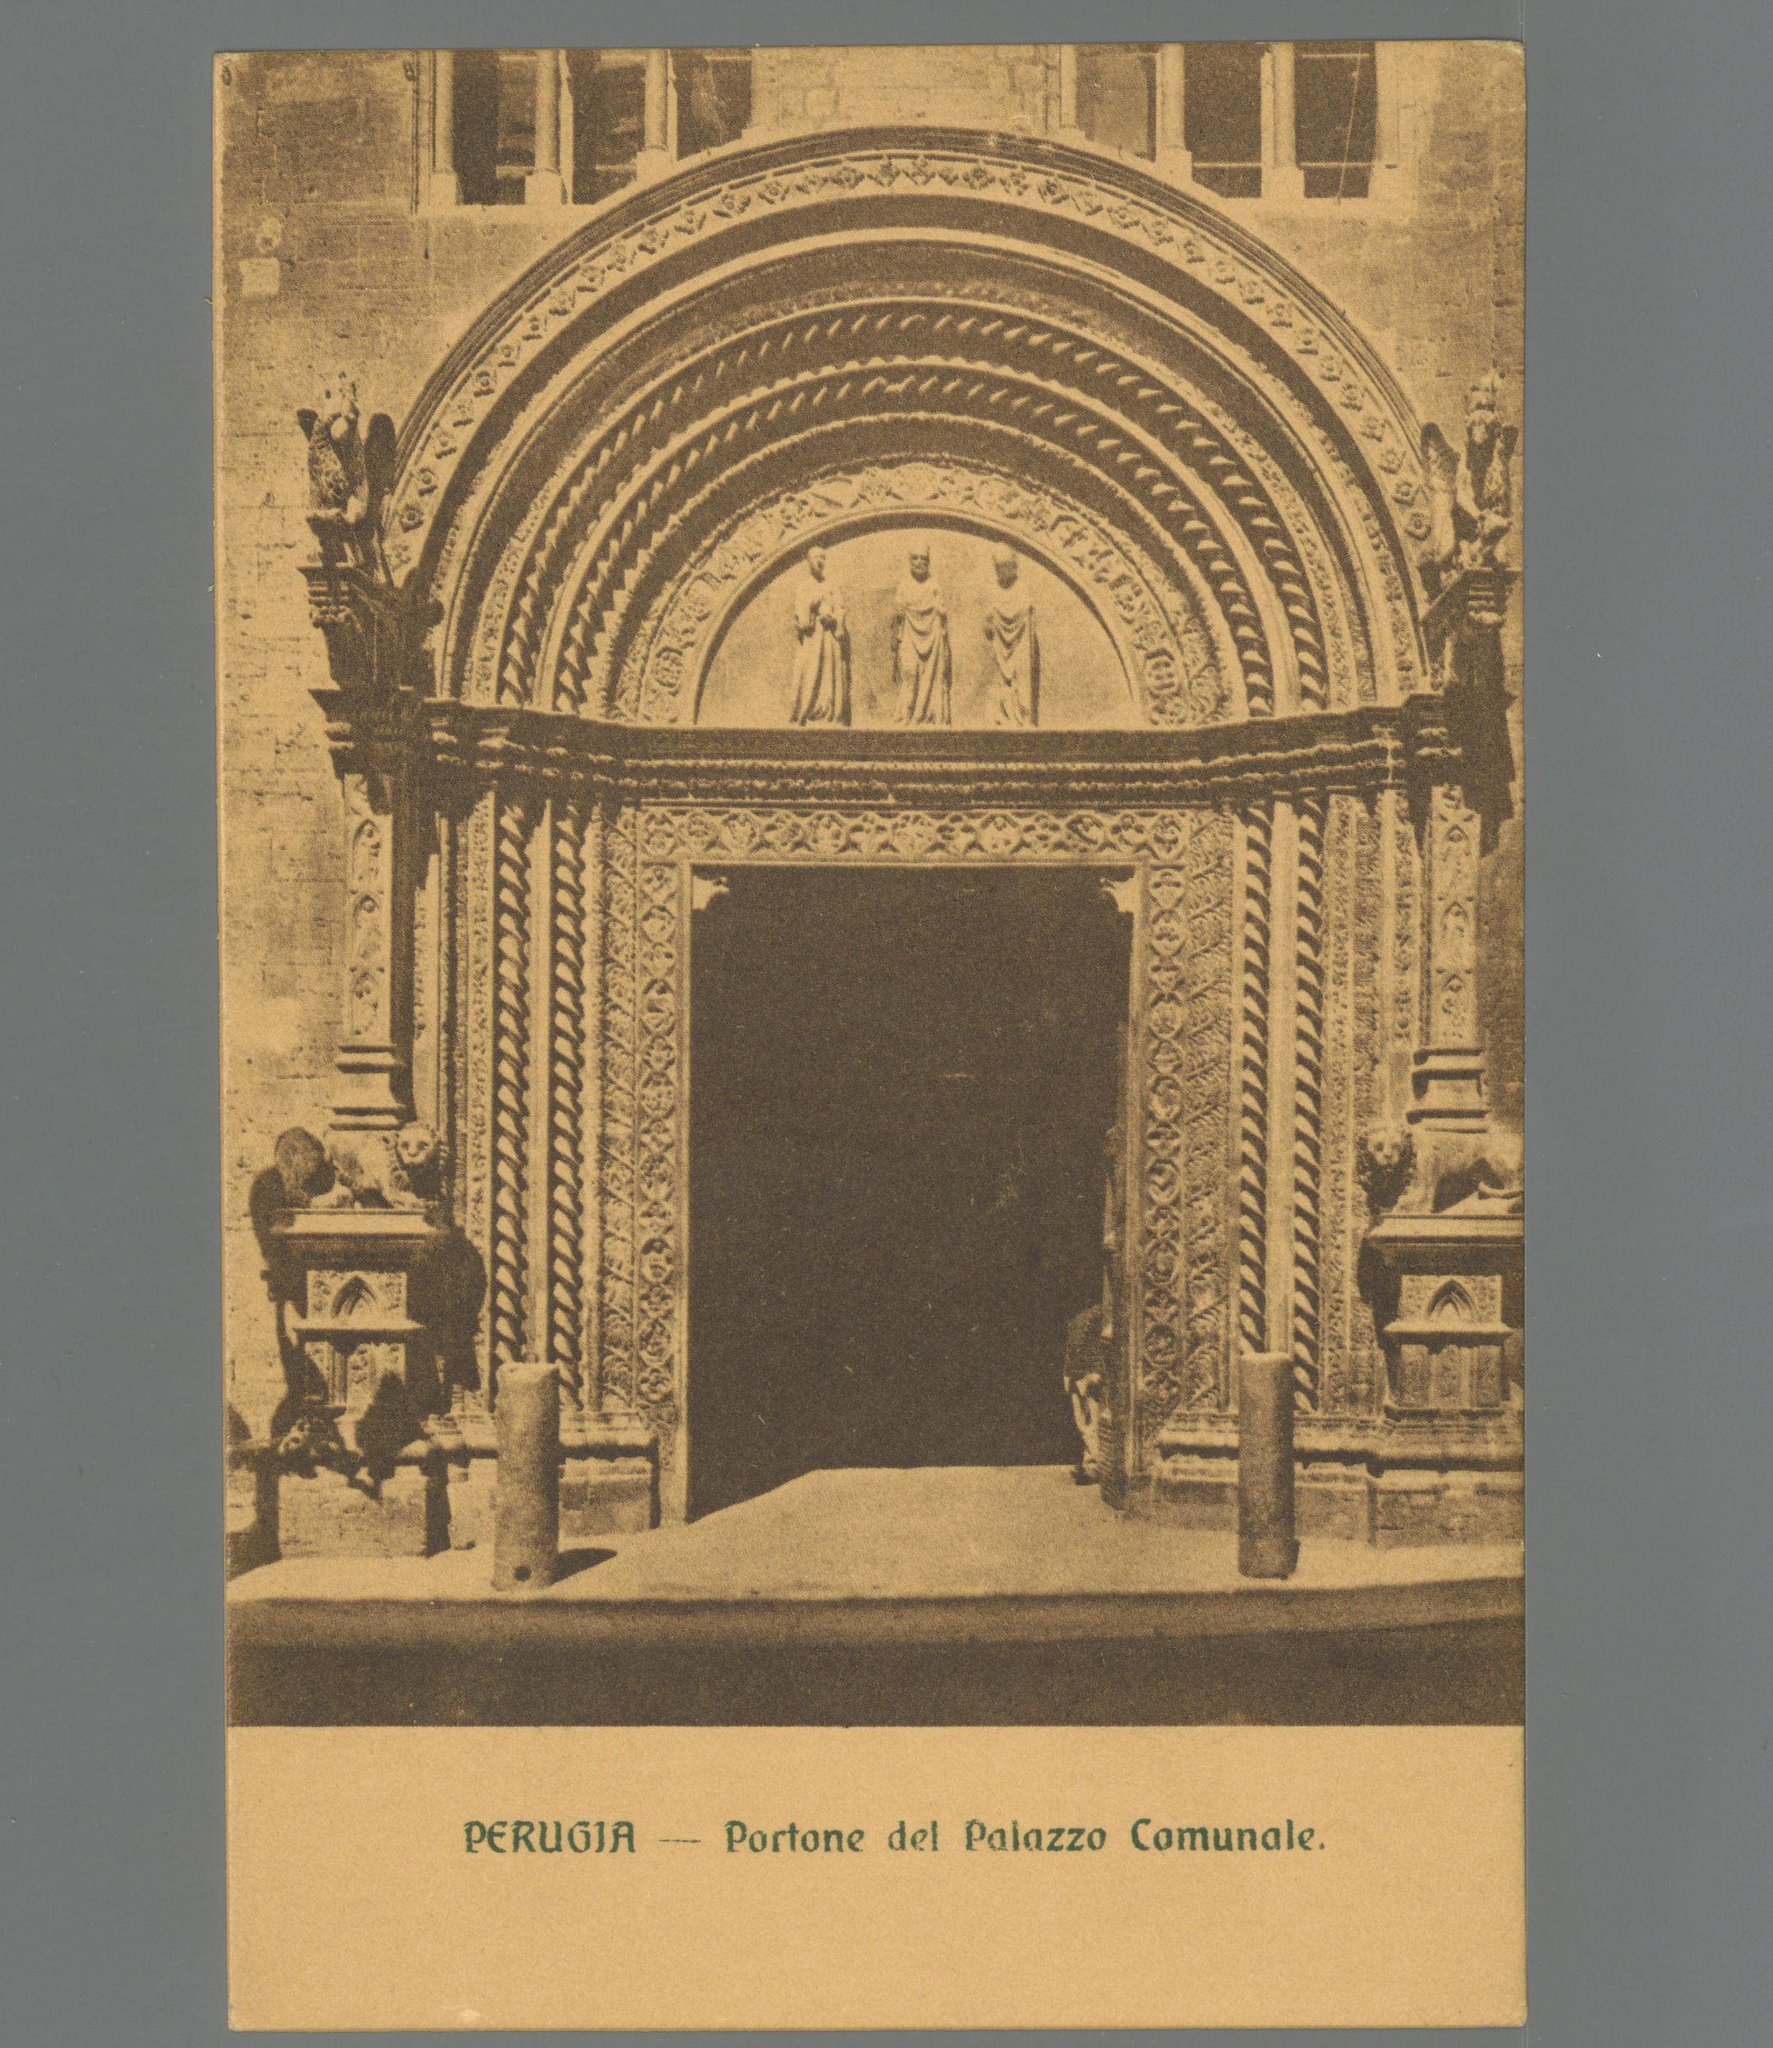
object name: photomechanical print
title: Perugia. Portone del Palazzo Comunale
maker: Anonymous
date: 1908-1914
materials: cardboard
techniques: photograph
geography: perugia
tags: palace